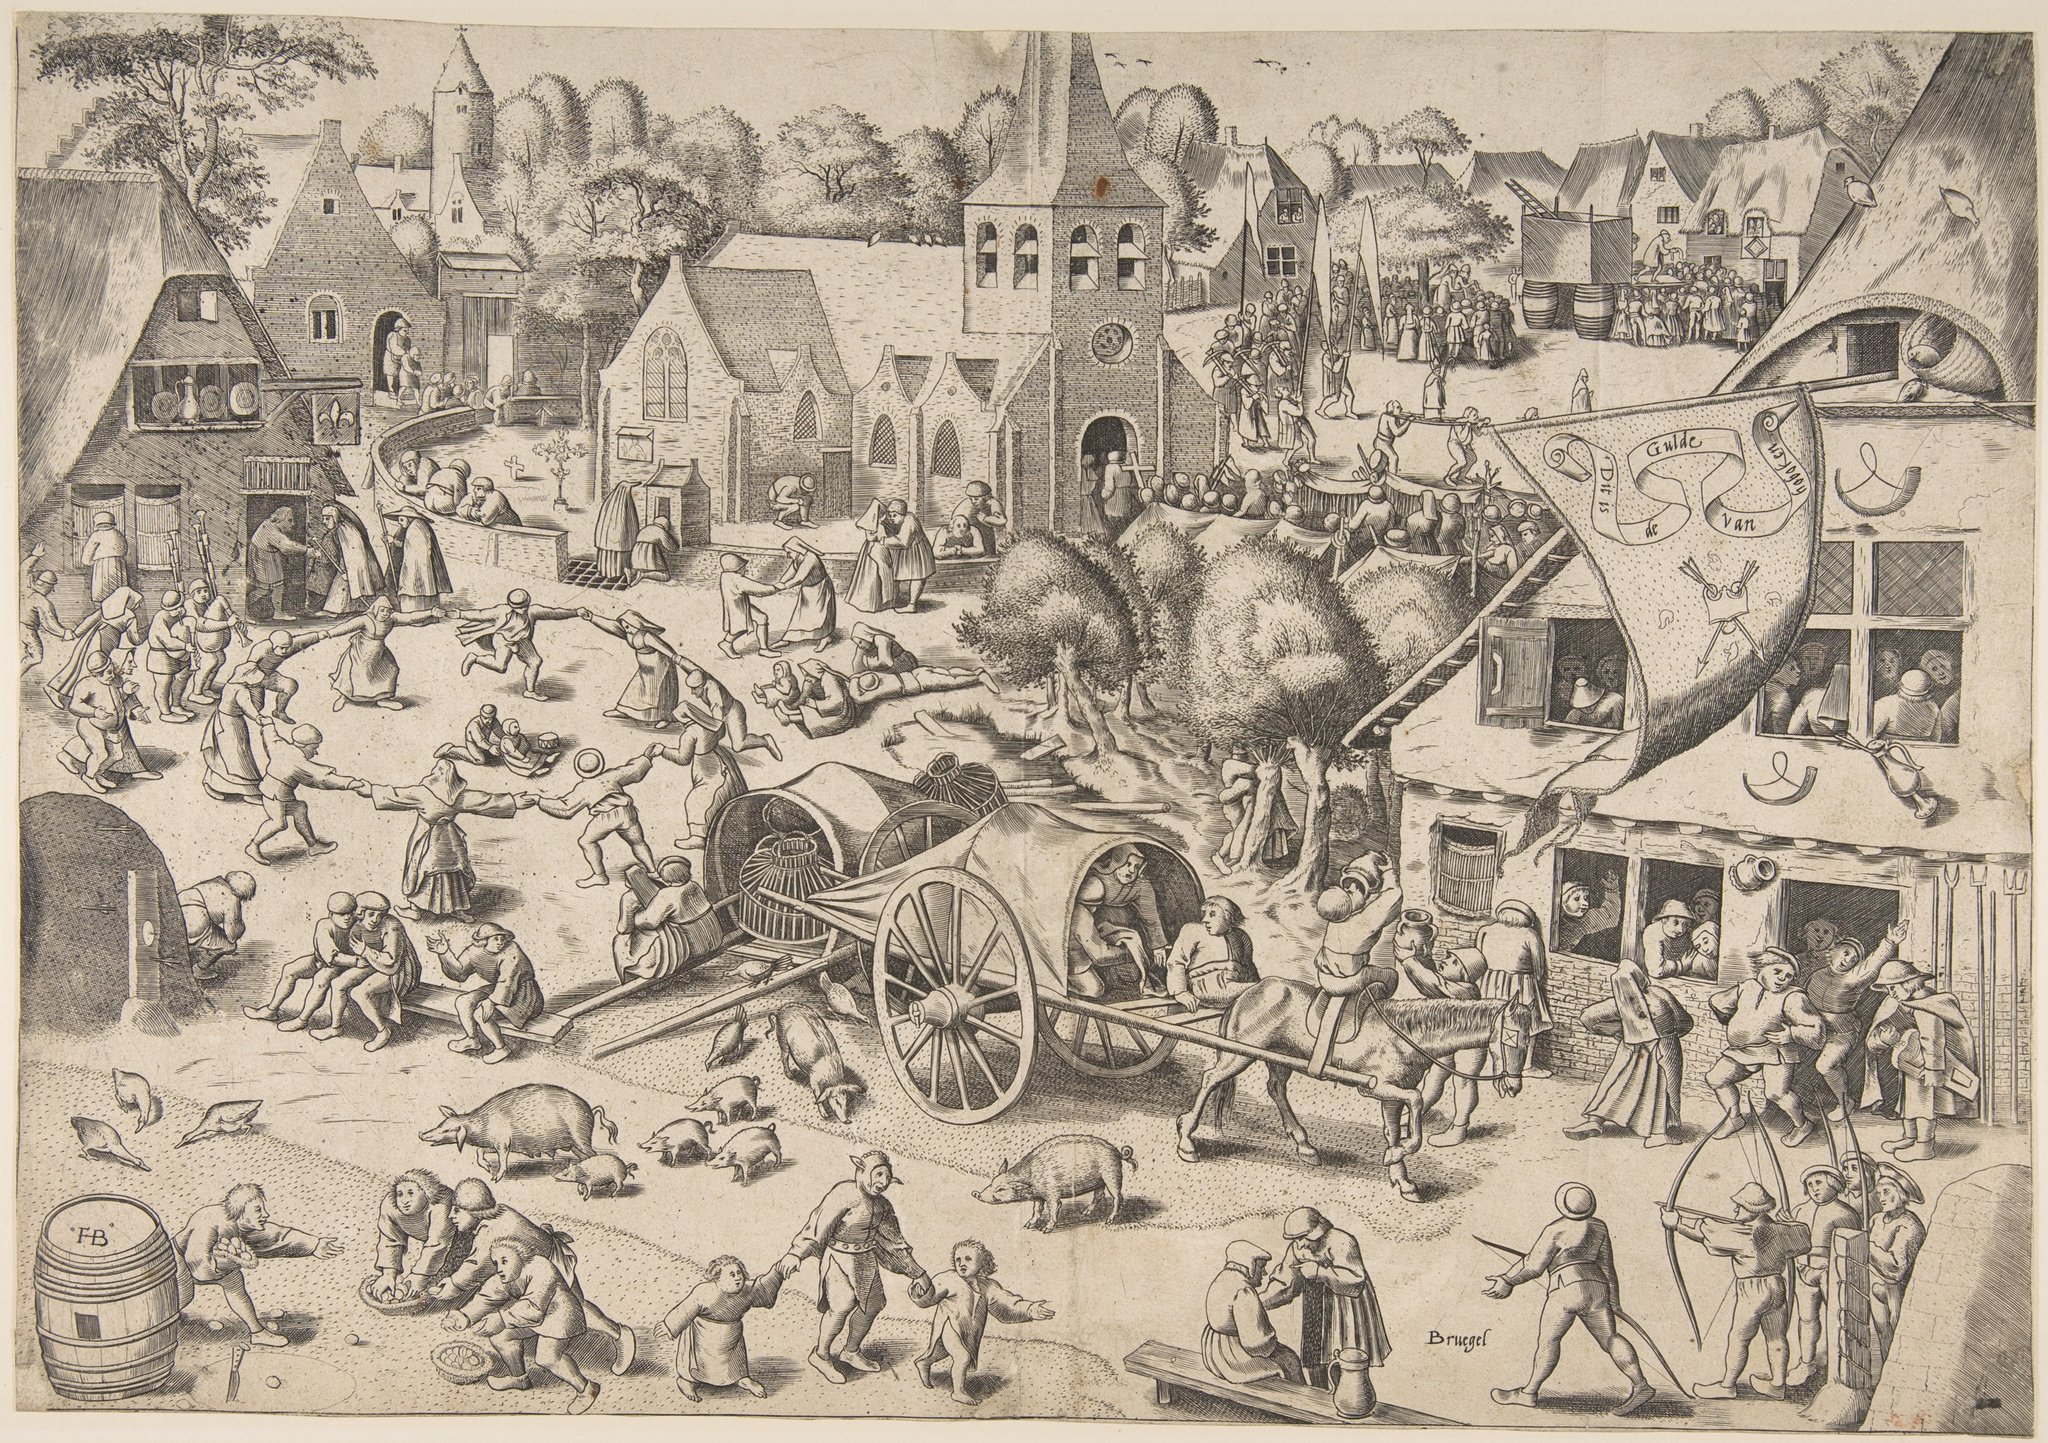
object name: print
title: The Kermis at Hoboken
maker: pieter bruegel the elder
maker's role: artist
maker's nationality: netherlandish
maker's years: 1525-1569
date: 1559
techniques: engraving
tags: animals,buildings,playing,flags,carts